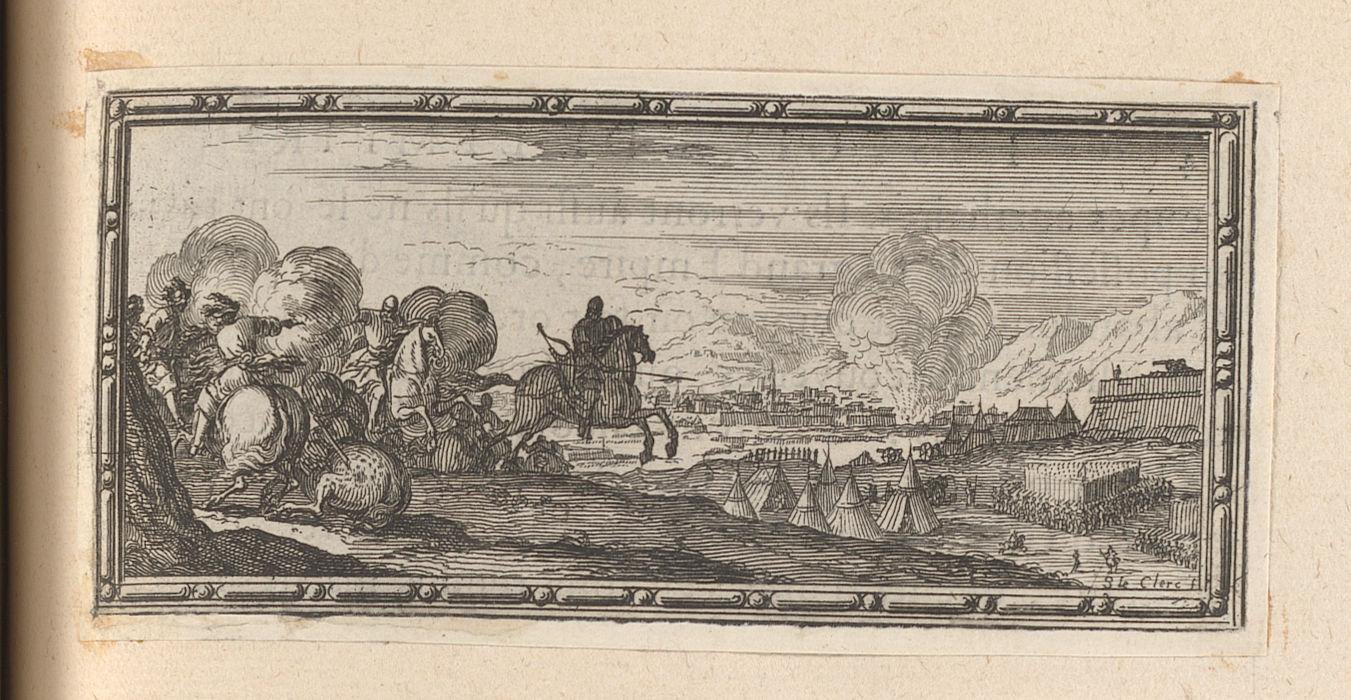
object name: album leaf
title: Vignet met een slag tussen Turken en Grieken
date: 1670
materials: paper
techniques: etching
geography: paris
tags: battle, vignette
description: Prent gebruikt voor: Rycaut, Paul. Histoire de l'état présent de l'Empire ottoman (...). Parijs: Sébastien Mabre-Cramoisy, 1670.